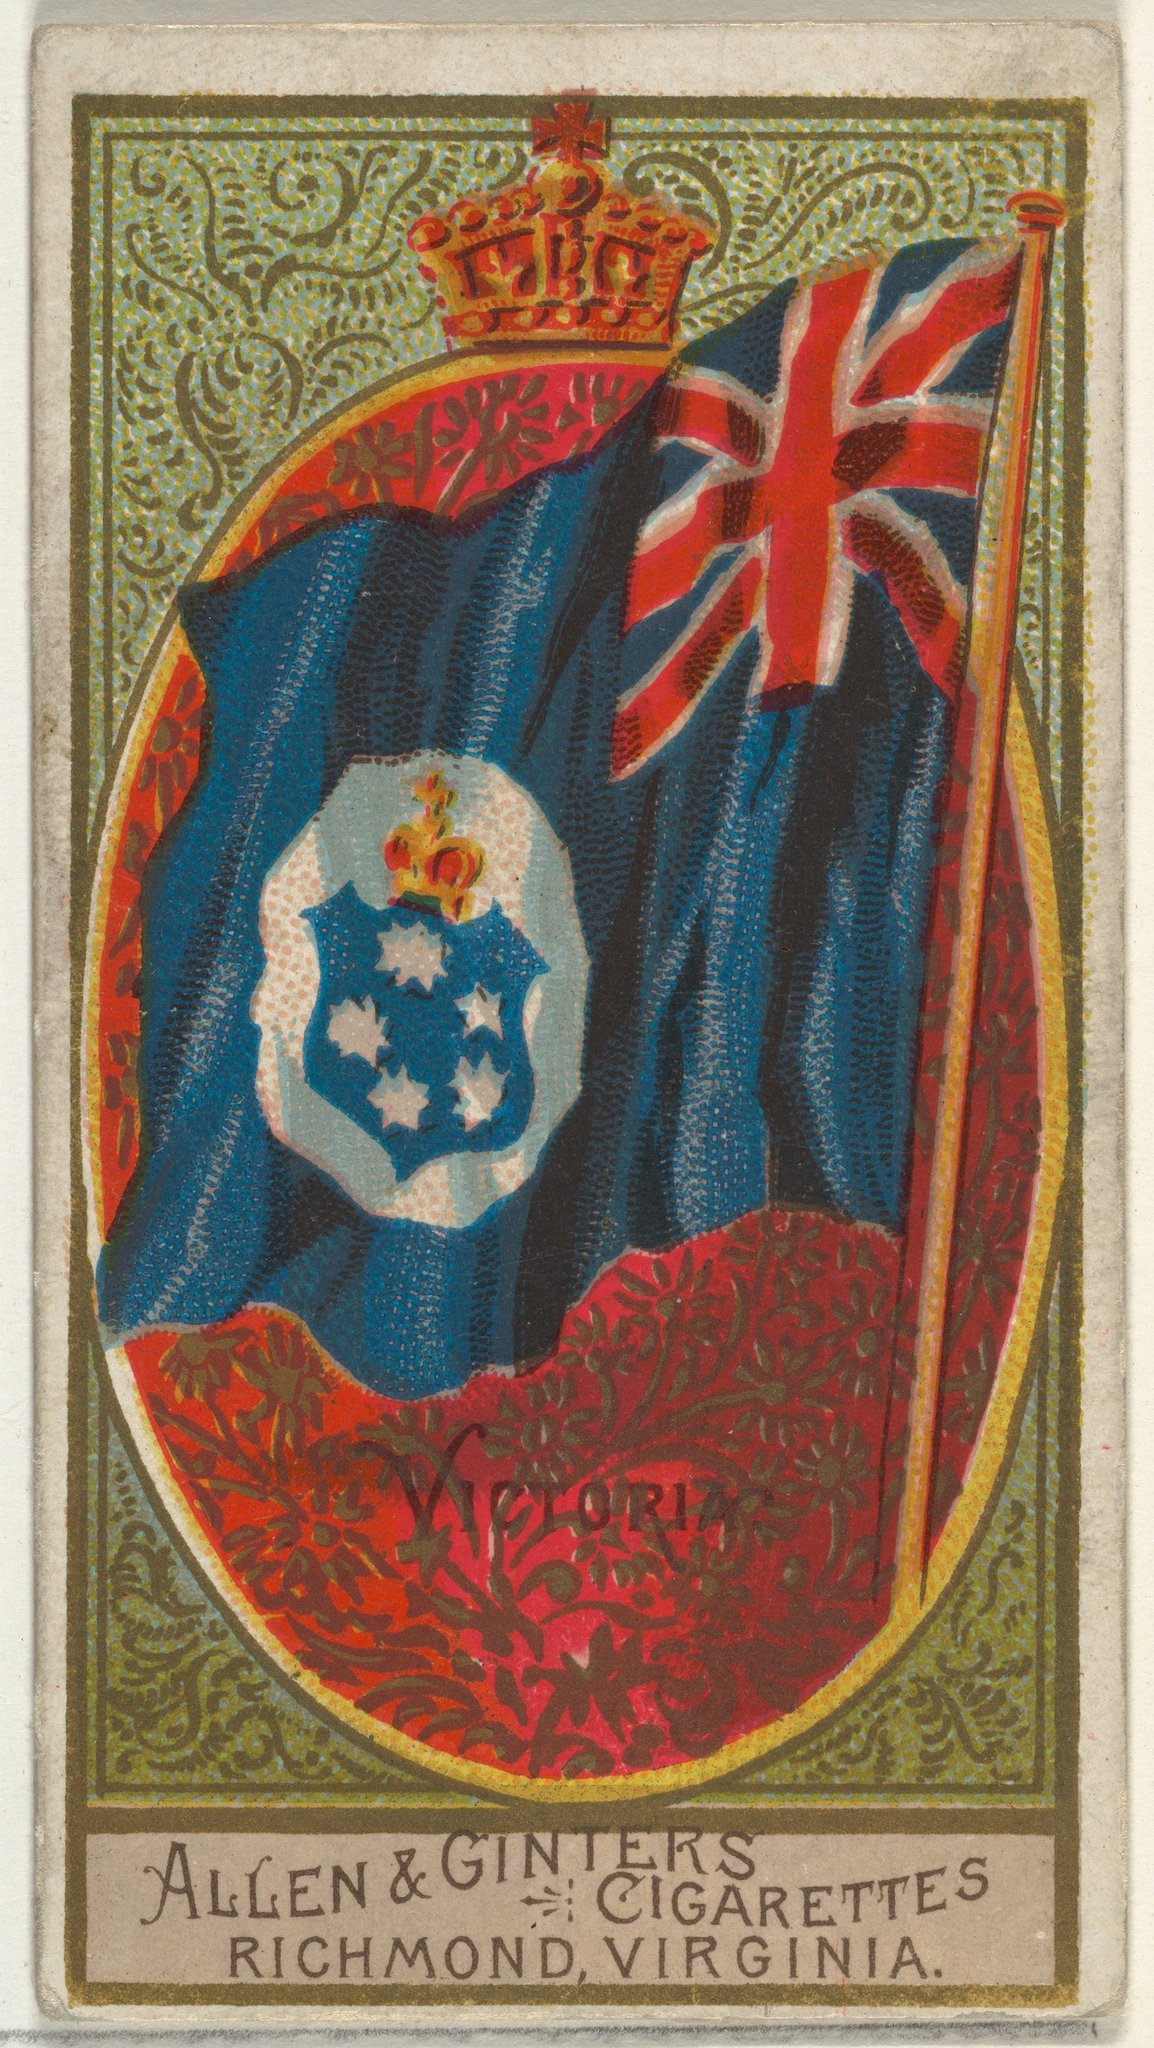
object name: print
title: Victoria, from Flags of All Nations, Series 2 (N10) for Allen & Ginter Cigarettes Brands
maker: allen & ginter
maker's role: publisher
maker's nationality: american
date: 1890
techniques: color lithograph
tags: coat of arms,flags